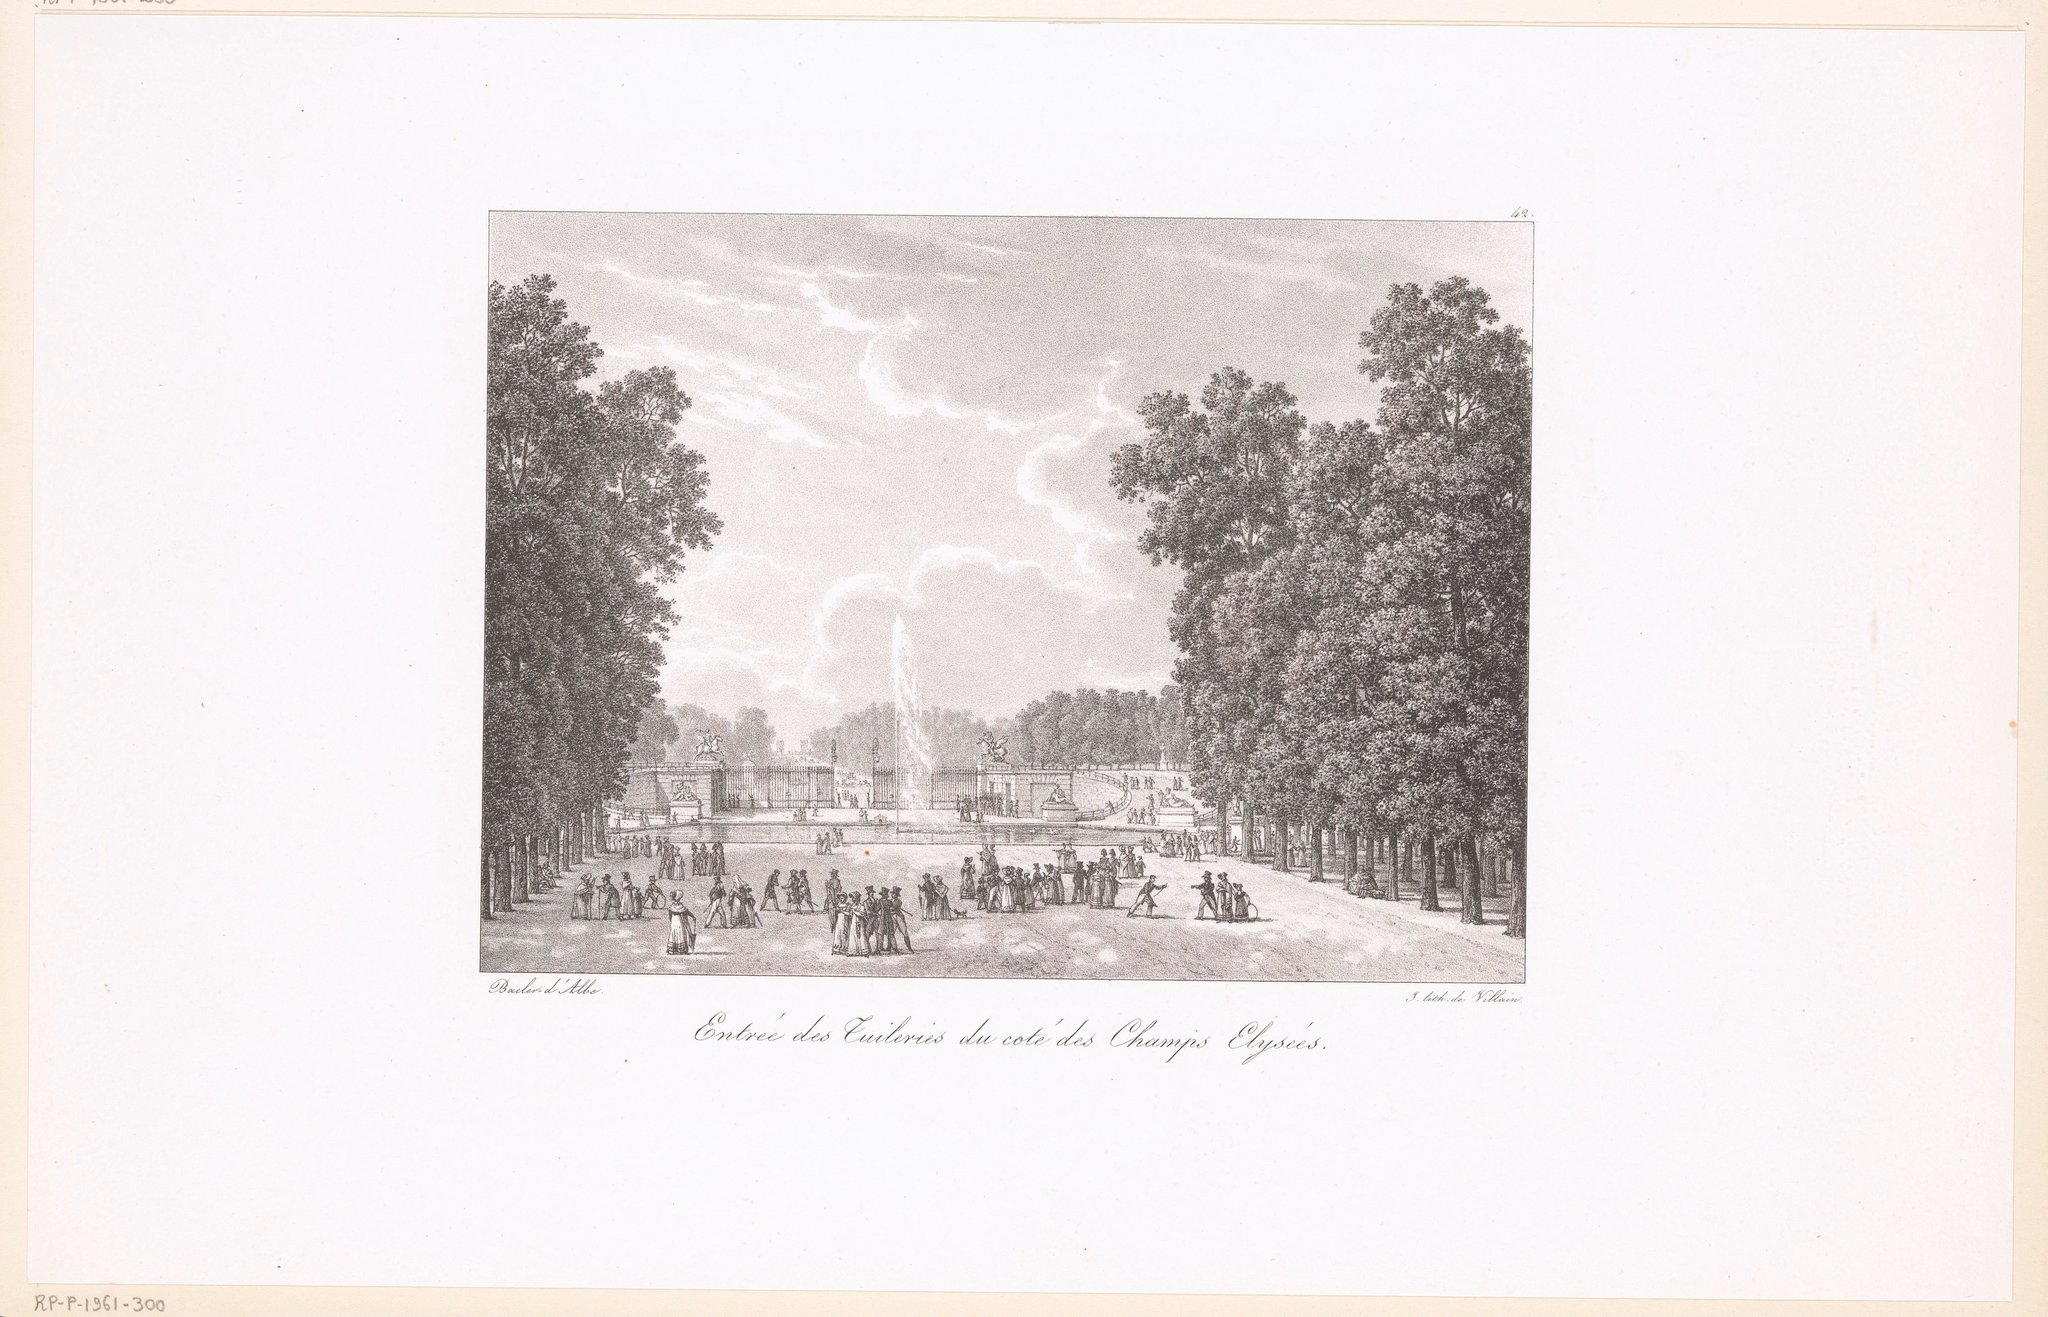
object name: print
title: Wandelaars bij de ingang van de Tuin van de Tuileriën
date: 1822-1824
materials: paper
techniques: lithograph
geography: paris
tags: strolling, garden fountain, public gardens, park